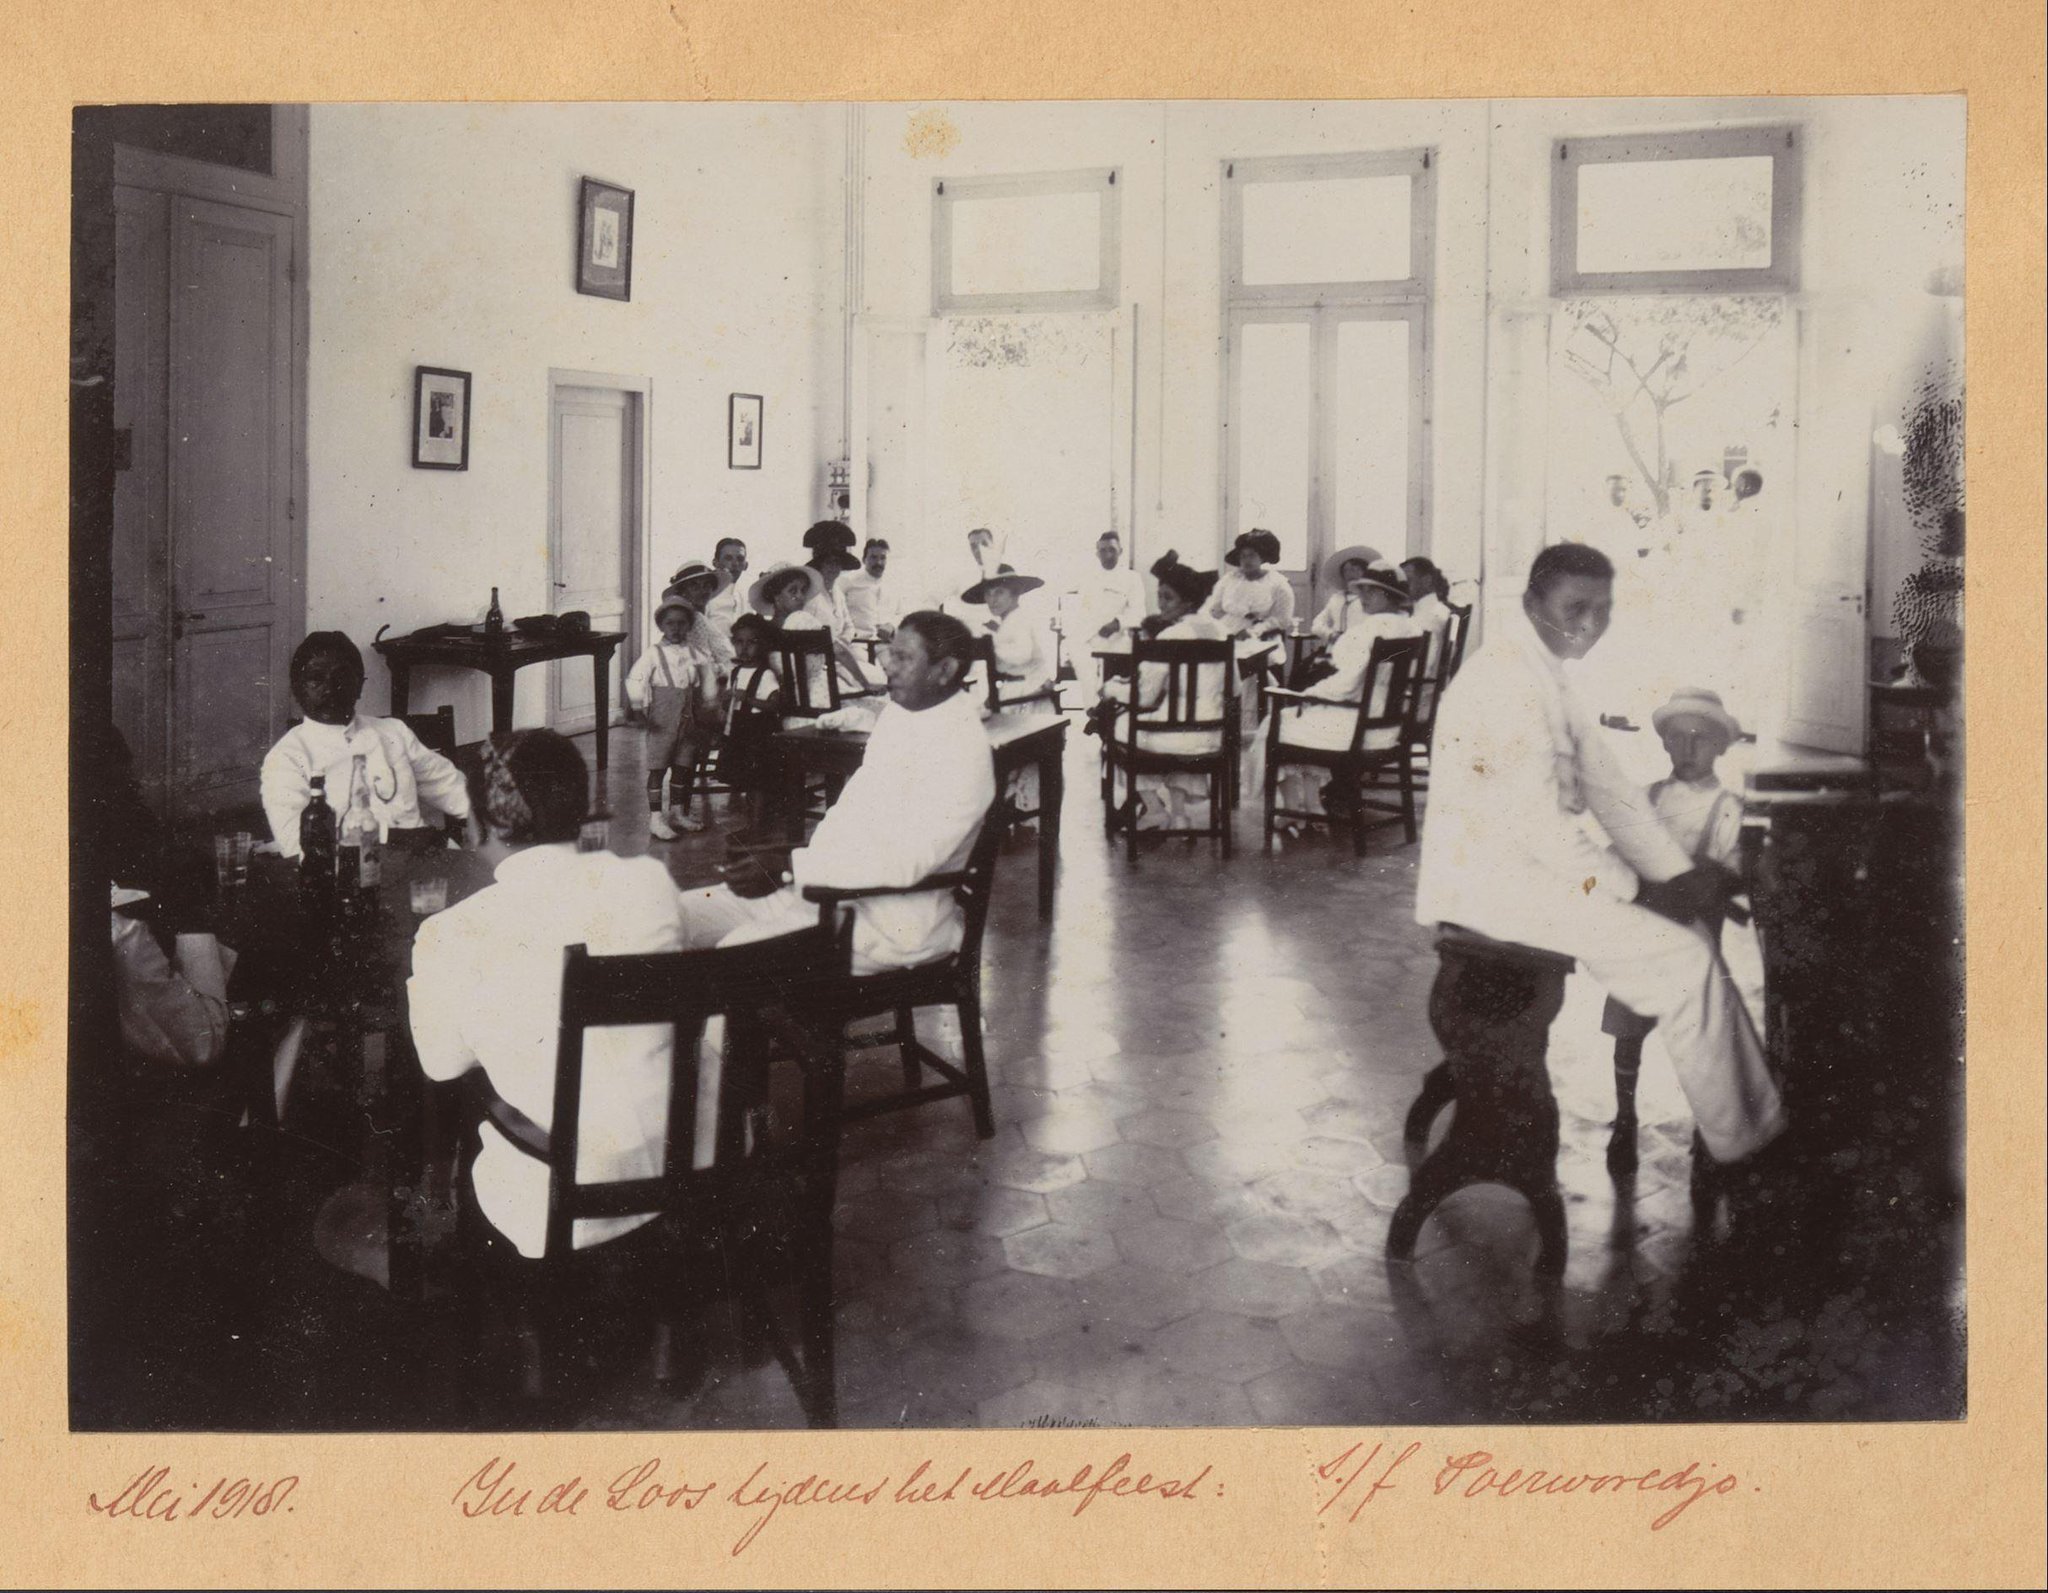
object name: photograph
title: Gezelschap in een suikerfabriek in Purworejo tijdens het maalfeest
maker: Anonymous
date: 1905-1918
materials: photographic support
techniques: gelatin silver print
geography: purworejo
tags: factory-interior, machine shop, private festivities, merry company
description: Onderdeel van Familiealbum met foto's van een familie in de voormalige kolonie Nederlands-Indië en van een suikerfabriek in Purworejo.